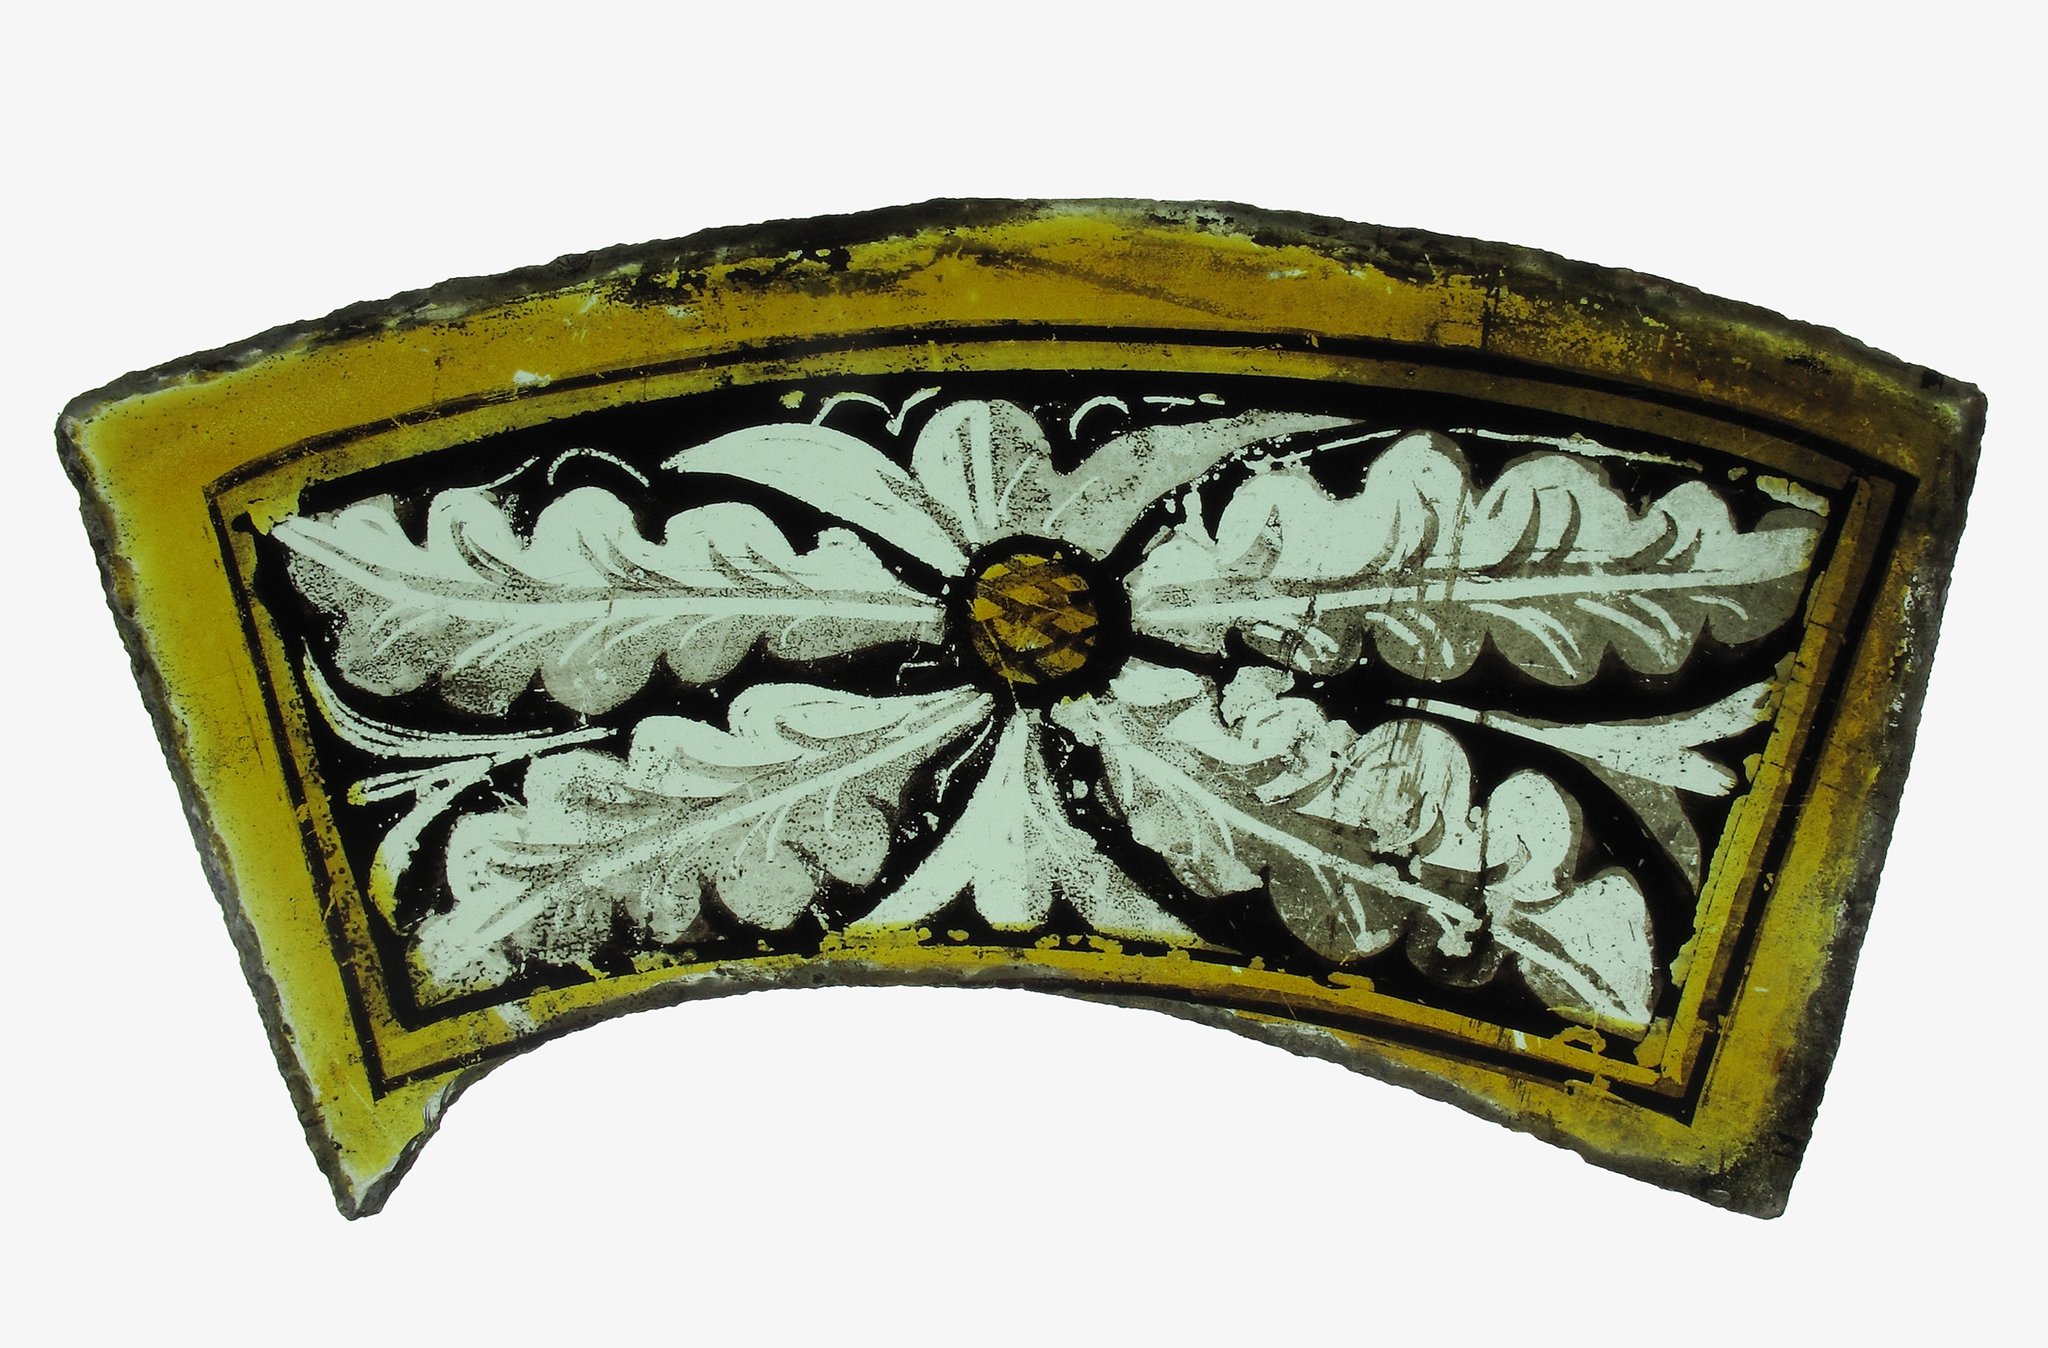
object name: fragment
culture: european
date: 1401-1500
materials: glass, metal, paint